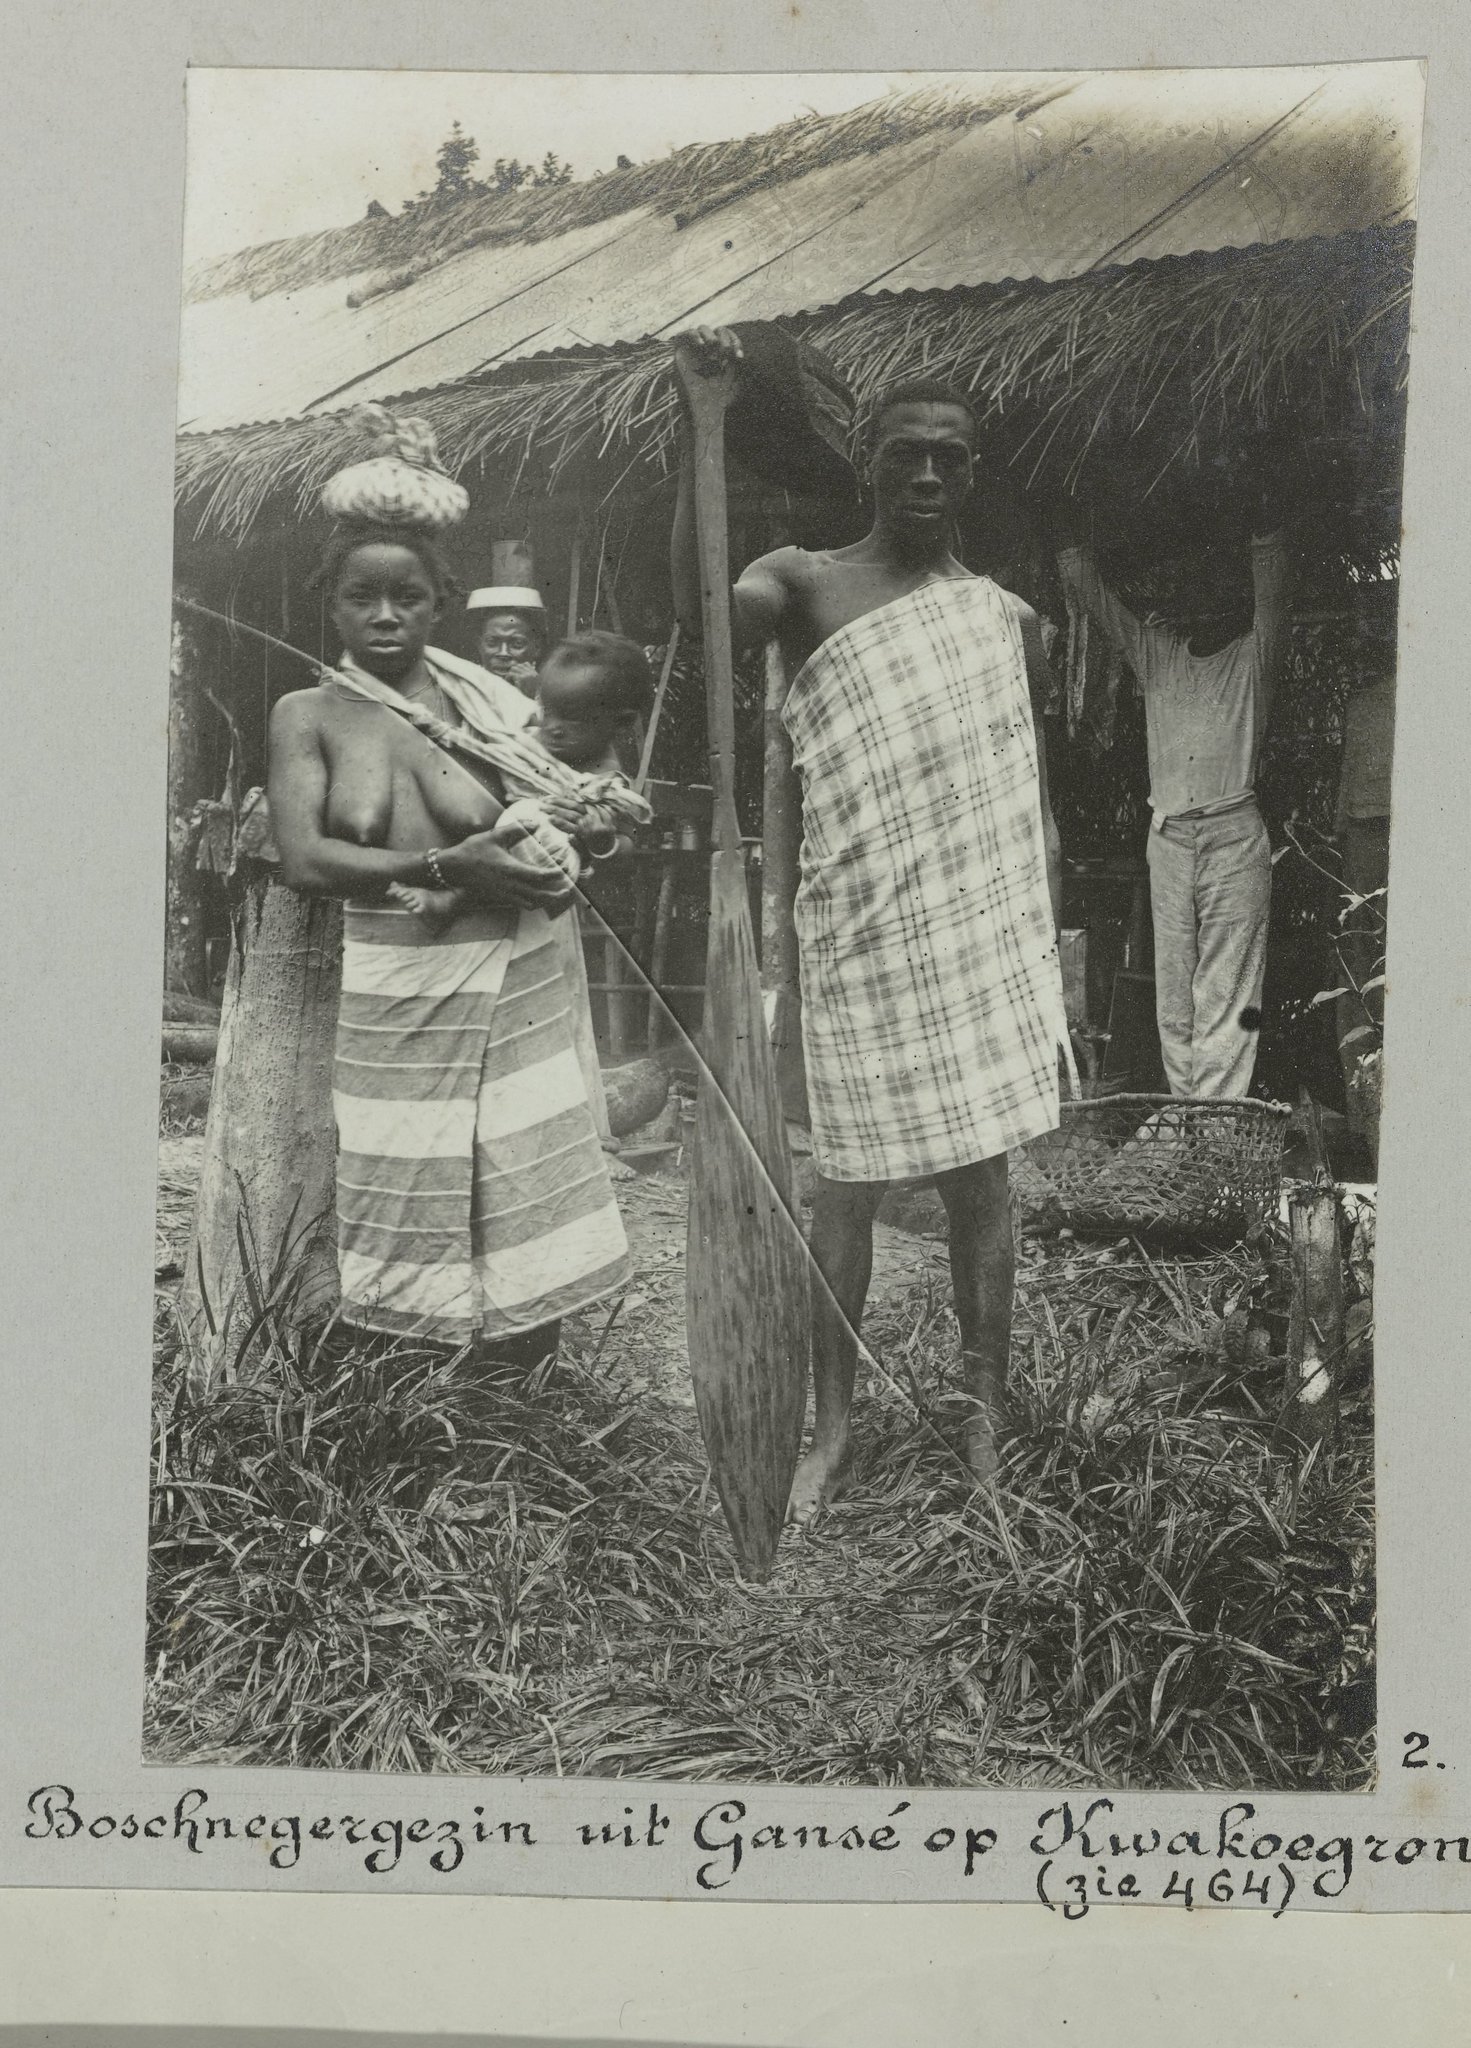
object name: photograph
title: Marrongezin uit het dorp Gansee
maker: hendrik doijer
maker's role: engineer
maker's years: 1863-1925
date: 1903-1910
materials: photographic support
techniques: gelatin silver print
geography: suriname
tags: suriname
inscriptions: inscription: ‘2. / Boschnegergezin uit Gansé op Kwakoegron. (zie 4G4)’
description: Marrongezin uit het dorp Gansee staande voor een huis te Kwakoegron, de man houdt zijn hand op een houten roeispaan. Onderdeel van het fotoalbum Souvenir de Voyage (deel 1), over het leven van de familie Doijer in en rond de plantage Ma Retraite in Suriname in de jaren 1903-1910.